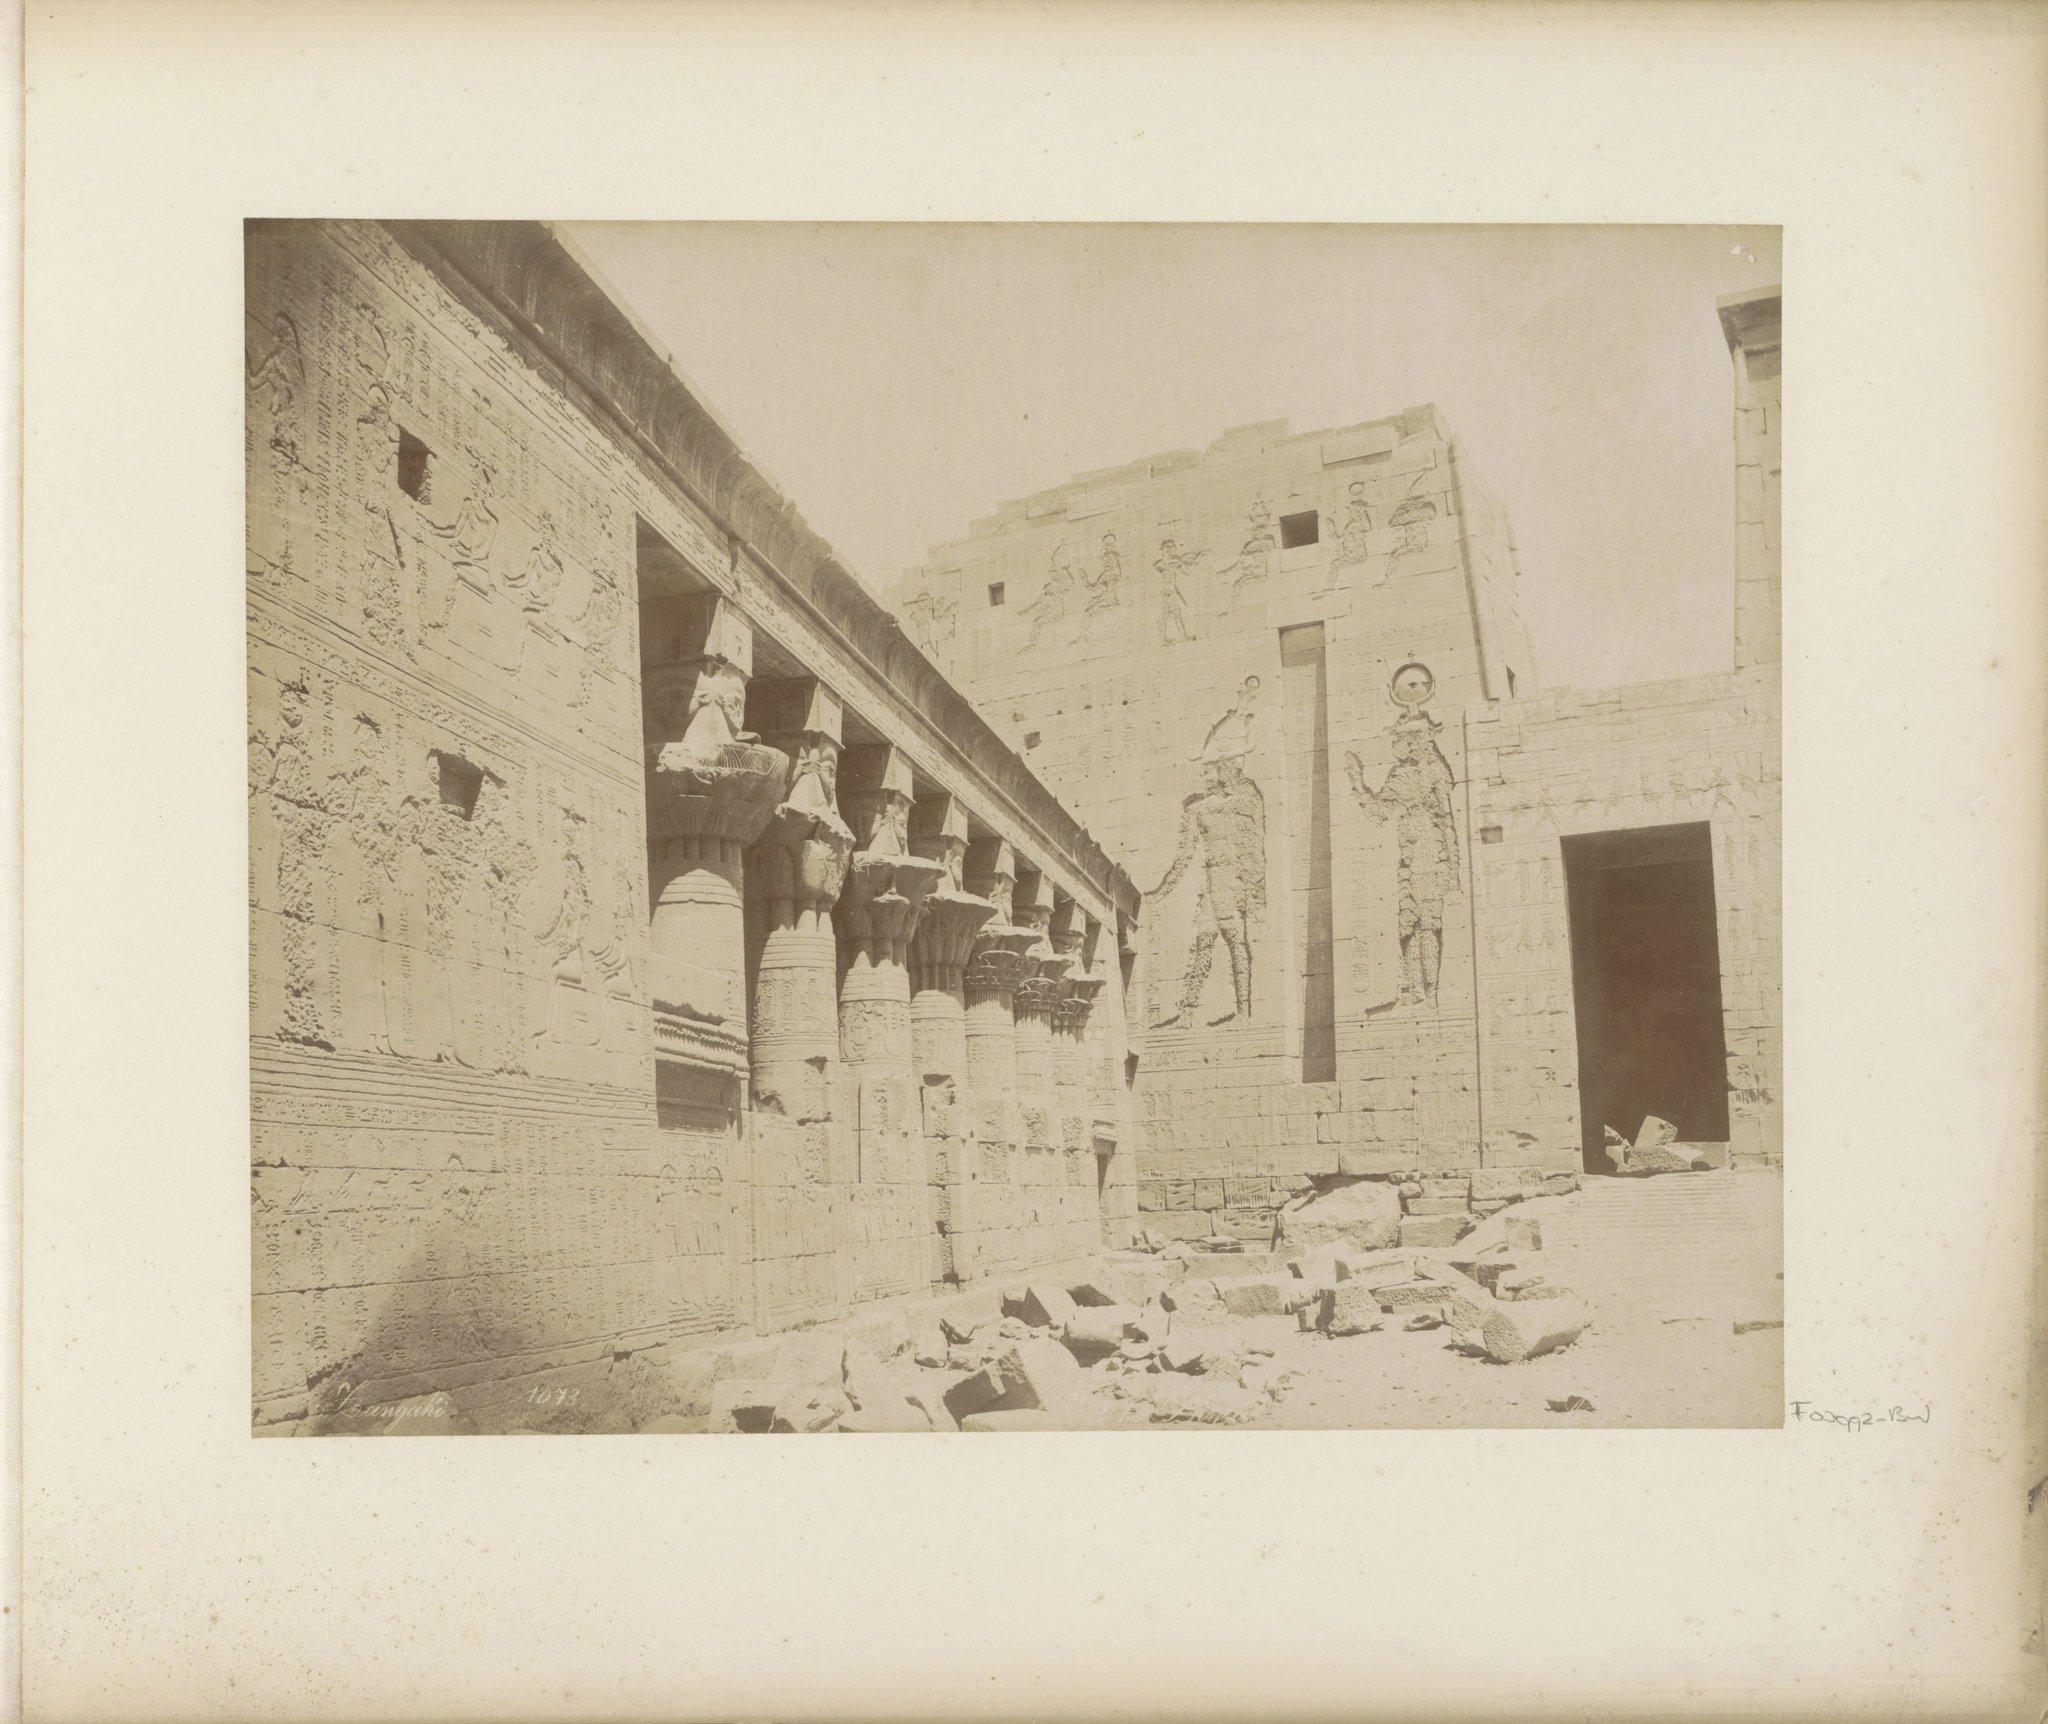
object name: photograph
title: Zuilengalerij van de Tempel van Isis op het eiland Philae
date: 1870-1890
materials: cardboard, paper, photographic support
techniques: albumen print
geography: philae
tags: temple, shrine ~ egyptian religion, colonnade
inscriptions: negative number: ‘1073’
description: Onderdeel van Reisalbum met 80 foto's van Egypte.